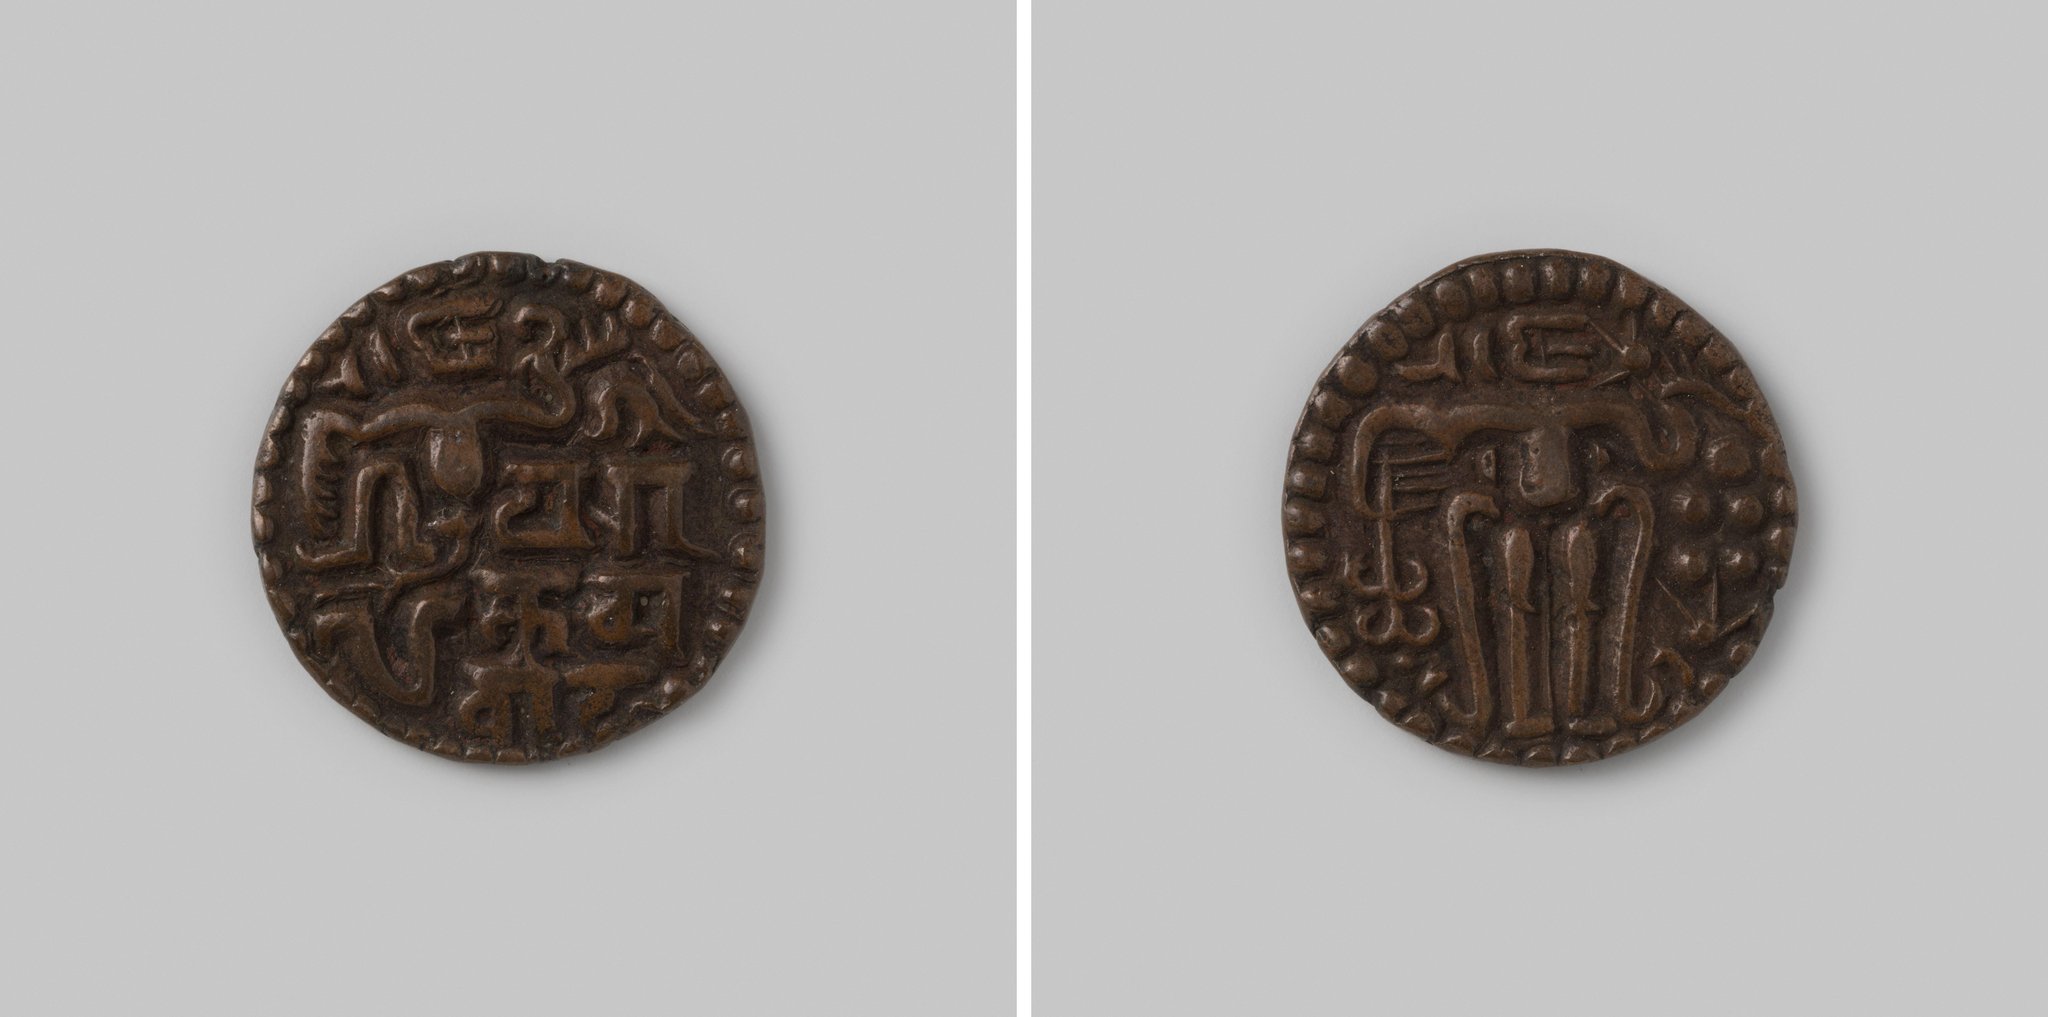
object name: coin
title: Sri Lanka, Ceylon, Parakrama Bahu II, 1236-1271, kahavanu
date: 1236-1271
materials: copper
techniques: striking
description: Koperen munt. Voorzijde: zittende figuur, waaromheen in vier regels opschrift in Nagari-tekens: Sri/Para/krama/Bahu. Keerzijde: staande figuur, waaromheen symbolen.